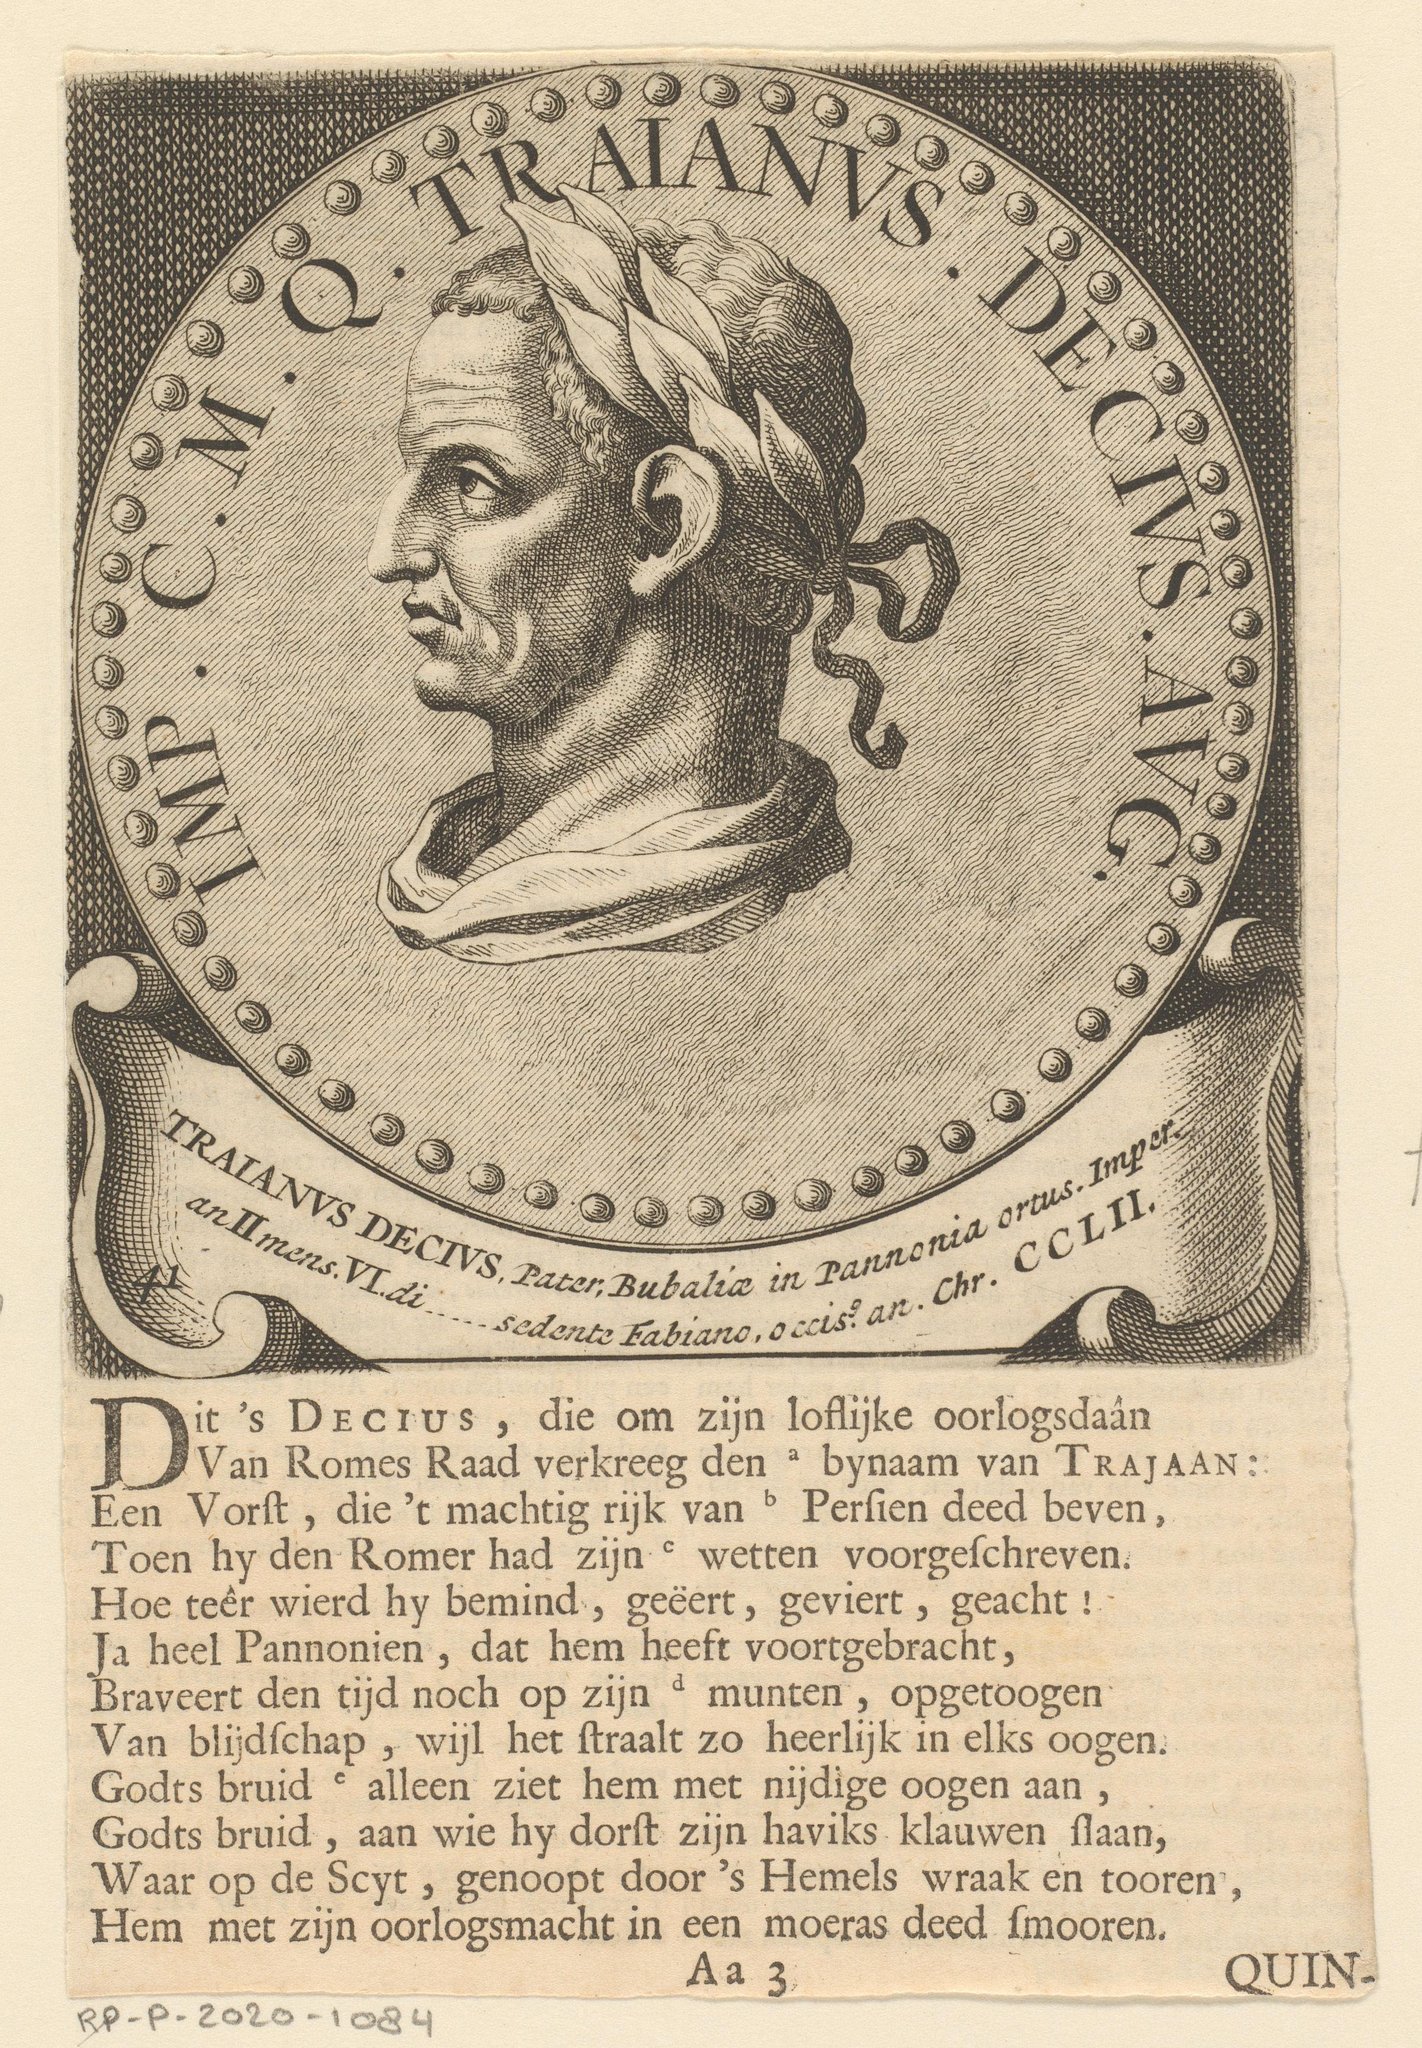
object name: print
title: Portret van keizer Decius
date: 1697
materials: paper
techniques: engraving, etching, letterpress printing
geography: utrecht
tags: historical persons, emperor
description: Prent uit: Bogaert, Abraham. De Roomsche monarchy, vertoont in de muntbeelden der westersche en oostersche keizeren (...). Utrecht: François Halma en Willem van de Water, 1697, p. 189. Eerste staat verschenen in een grotere prent met twaalf portretten, gedateerd 1695.